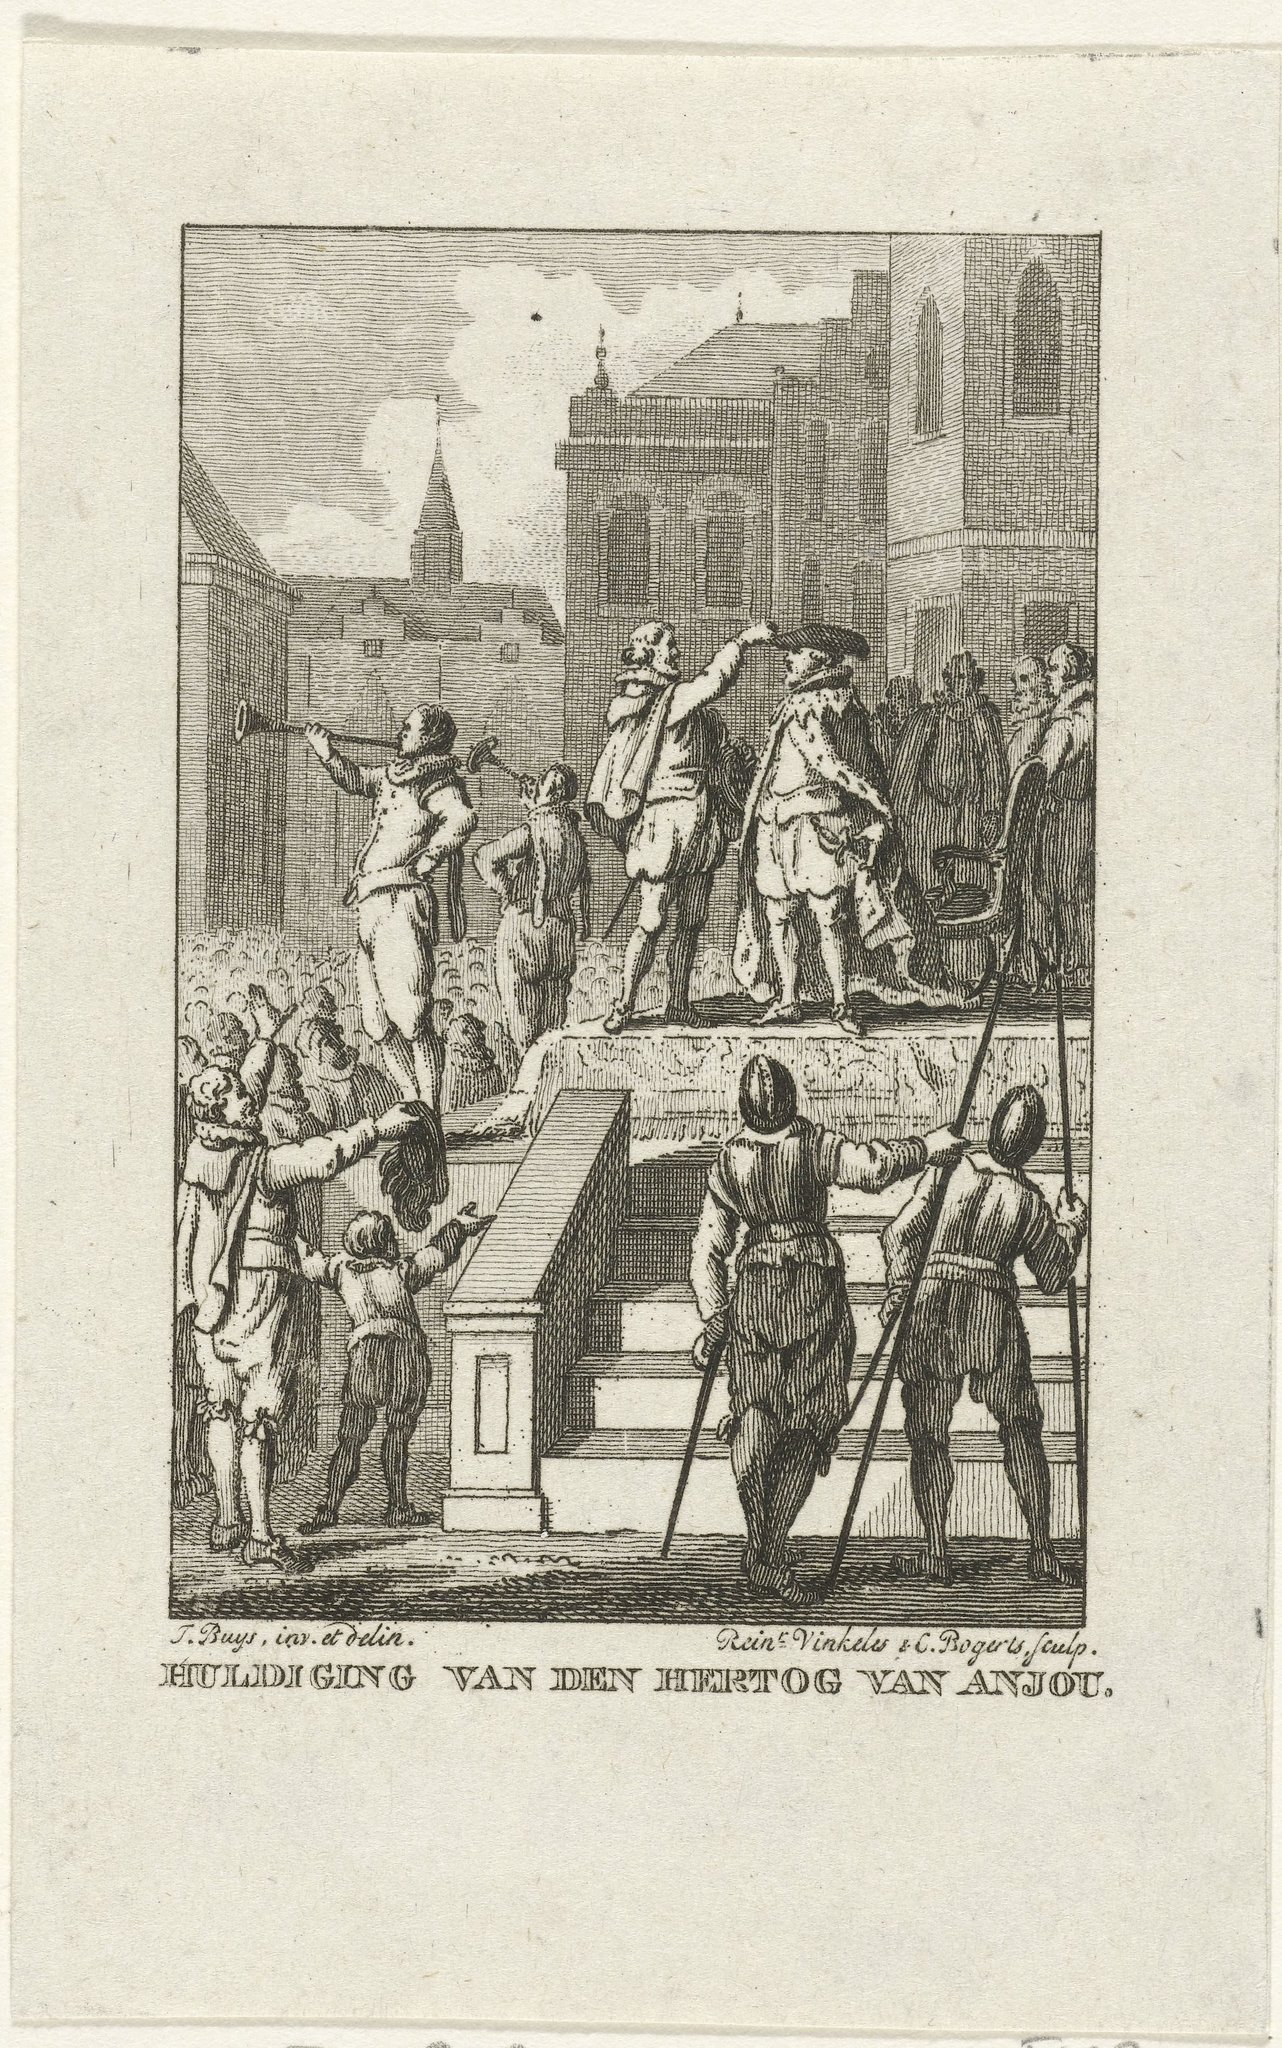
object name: print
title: Huldiging van den hertog van Anjou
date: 1780-1795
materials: paper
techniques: etching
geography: netherlands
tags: françois-hercule de valois (hertog van anjou), triumphal entry and public reception, pageant, 'entrée solennelle', 'joyeuse entrée', antwerp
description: Gebruikt als illustratie in: J. Fokke, Geschiedenissen der Vereenigde Nederlanden voor de vaderlandsche jeugd, Johannes Allart, Amsterdam 1783-1795, 25 delen, dl. V, pl. V.